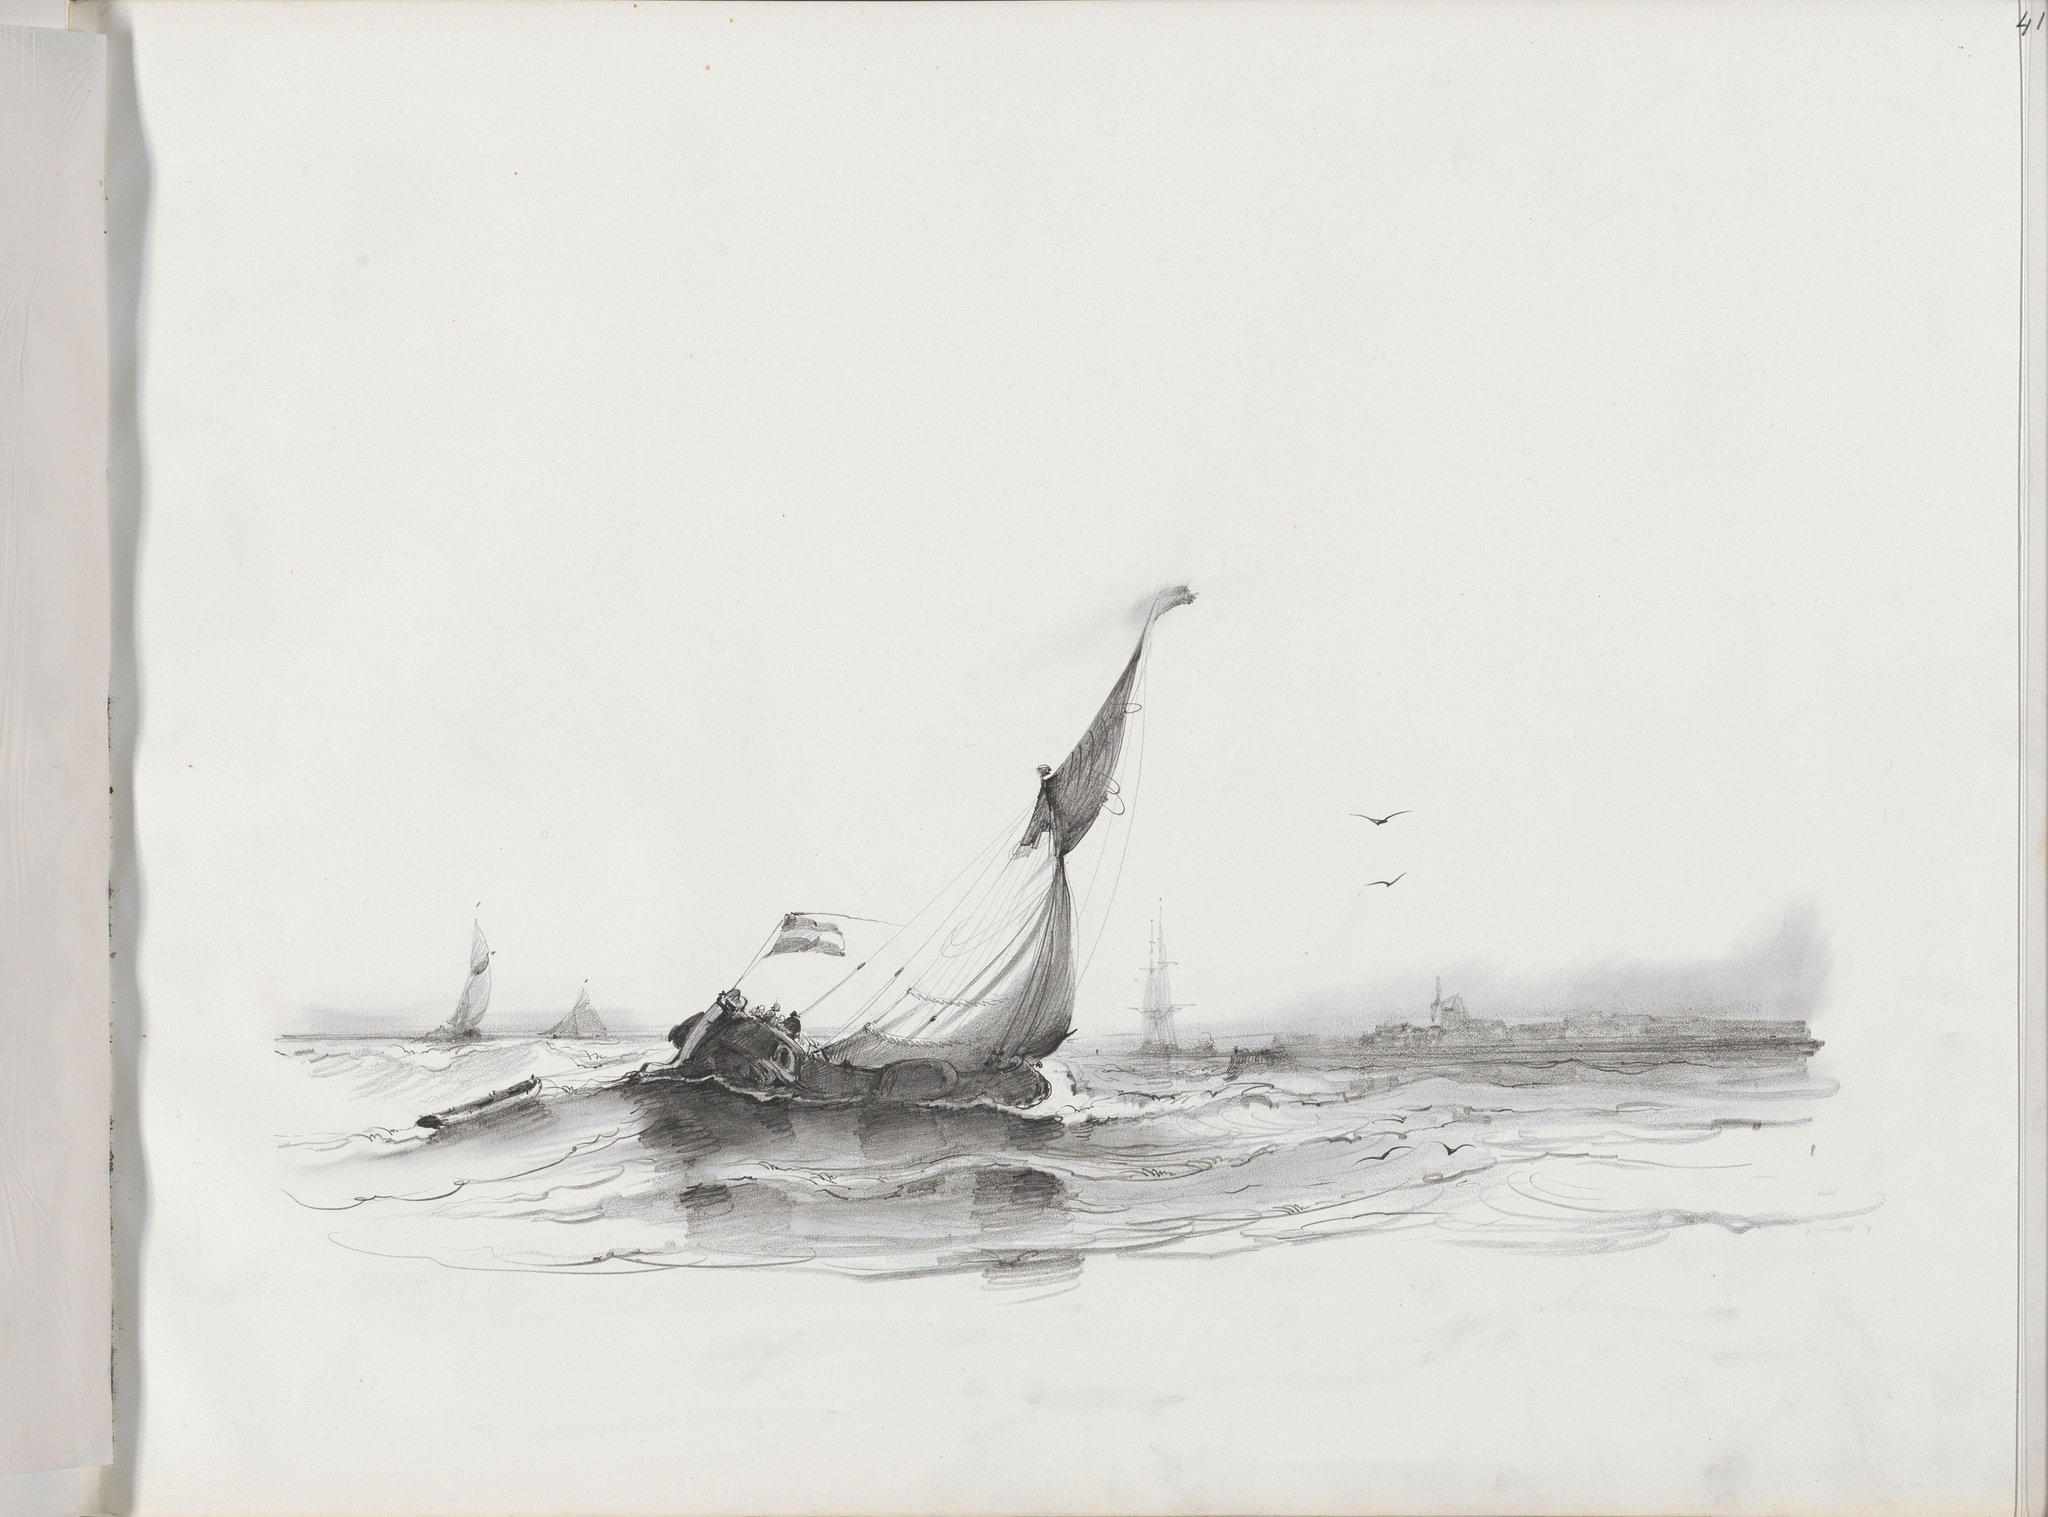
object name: sketchbook leaf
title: Zeilschip op een woelige zee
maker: albertus van beest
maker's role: draughtsman, print maker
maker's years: 1820-1860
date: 1830-1860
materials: paper, pencil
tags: city-view, and landscape with man-made constructions, sailing-ship, sailing-boat, landscapes with waters, waterscapes, seascapes (in the temperate zone)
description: Op de achtergrond bebouwing. Blad 41 recto uit een schetsboek met 46 bladen.